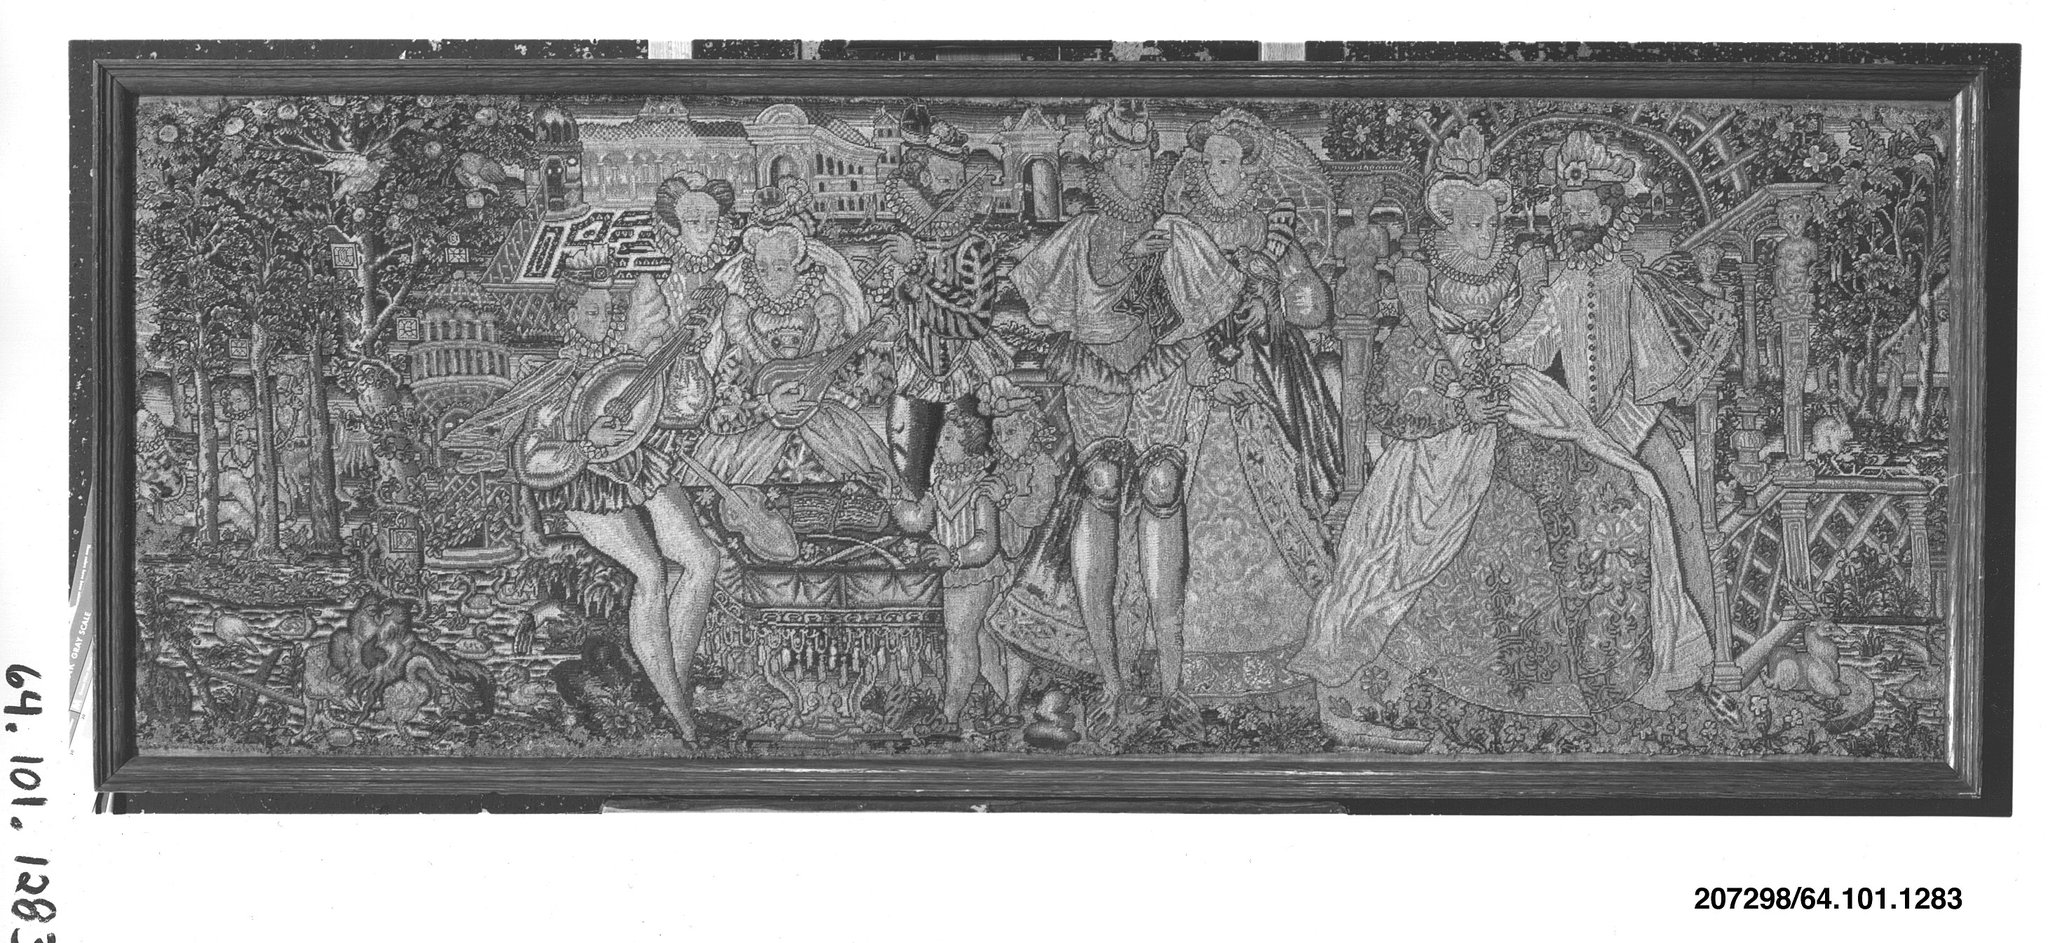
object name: panel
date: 1576-1600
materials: canvas, silk, wool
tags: musical instruments,gardens,men,women,musicians